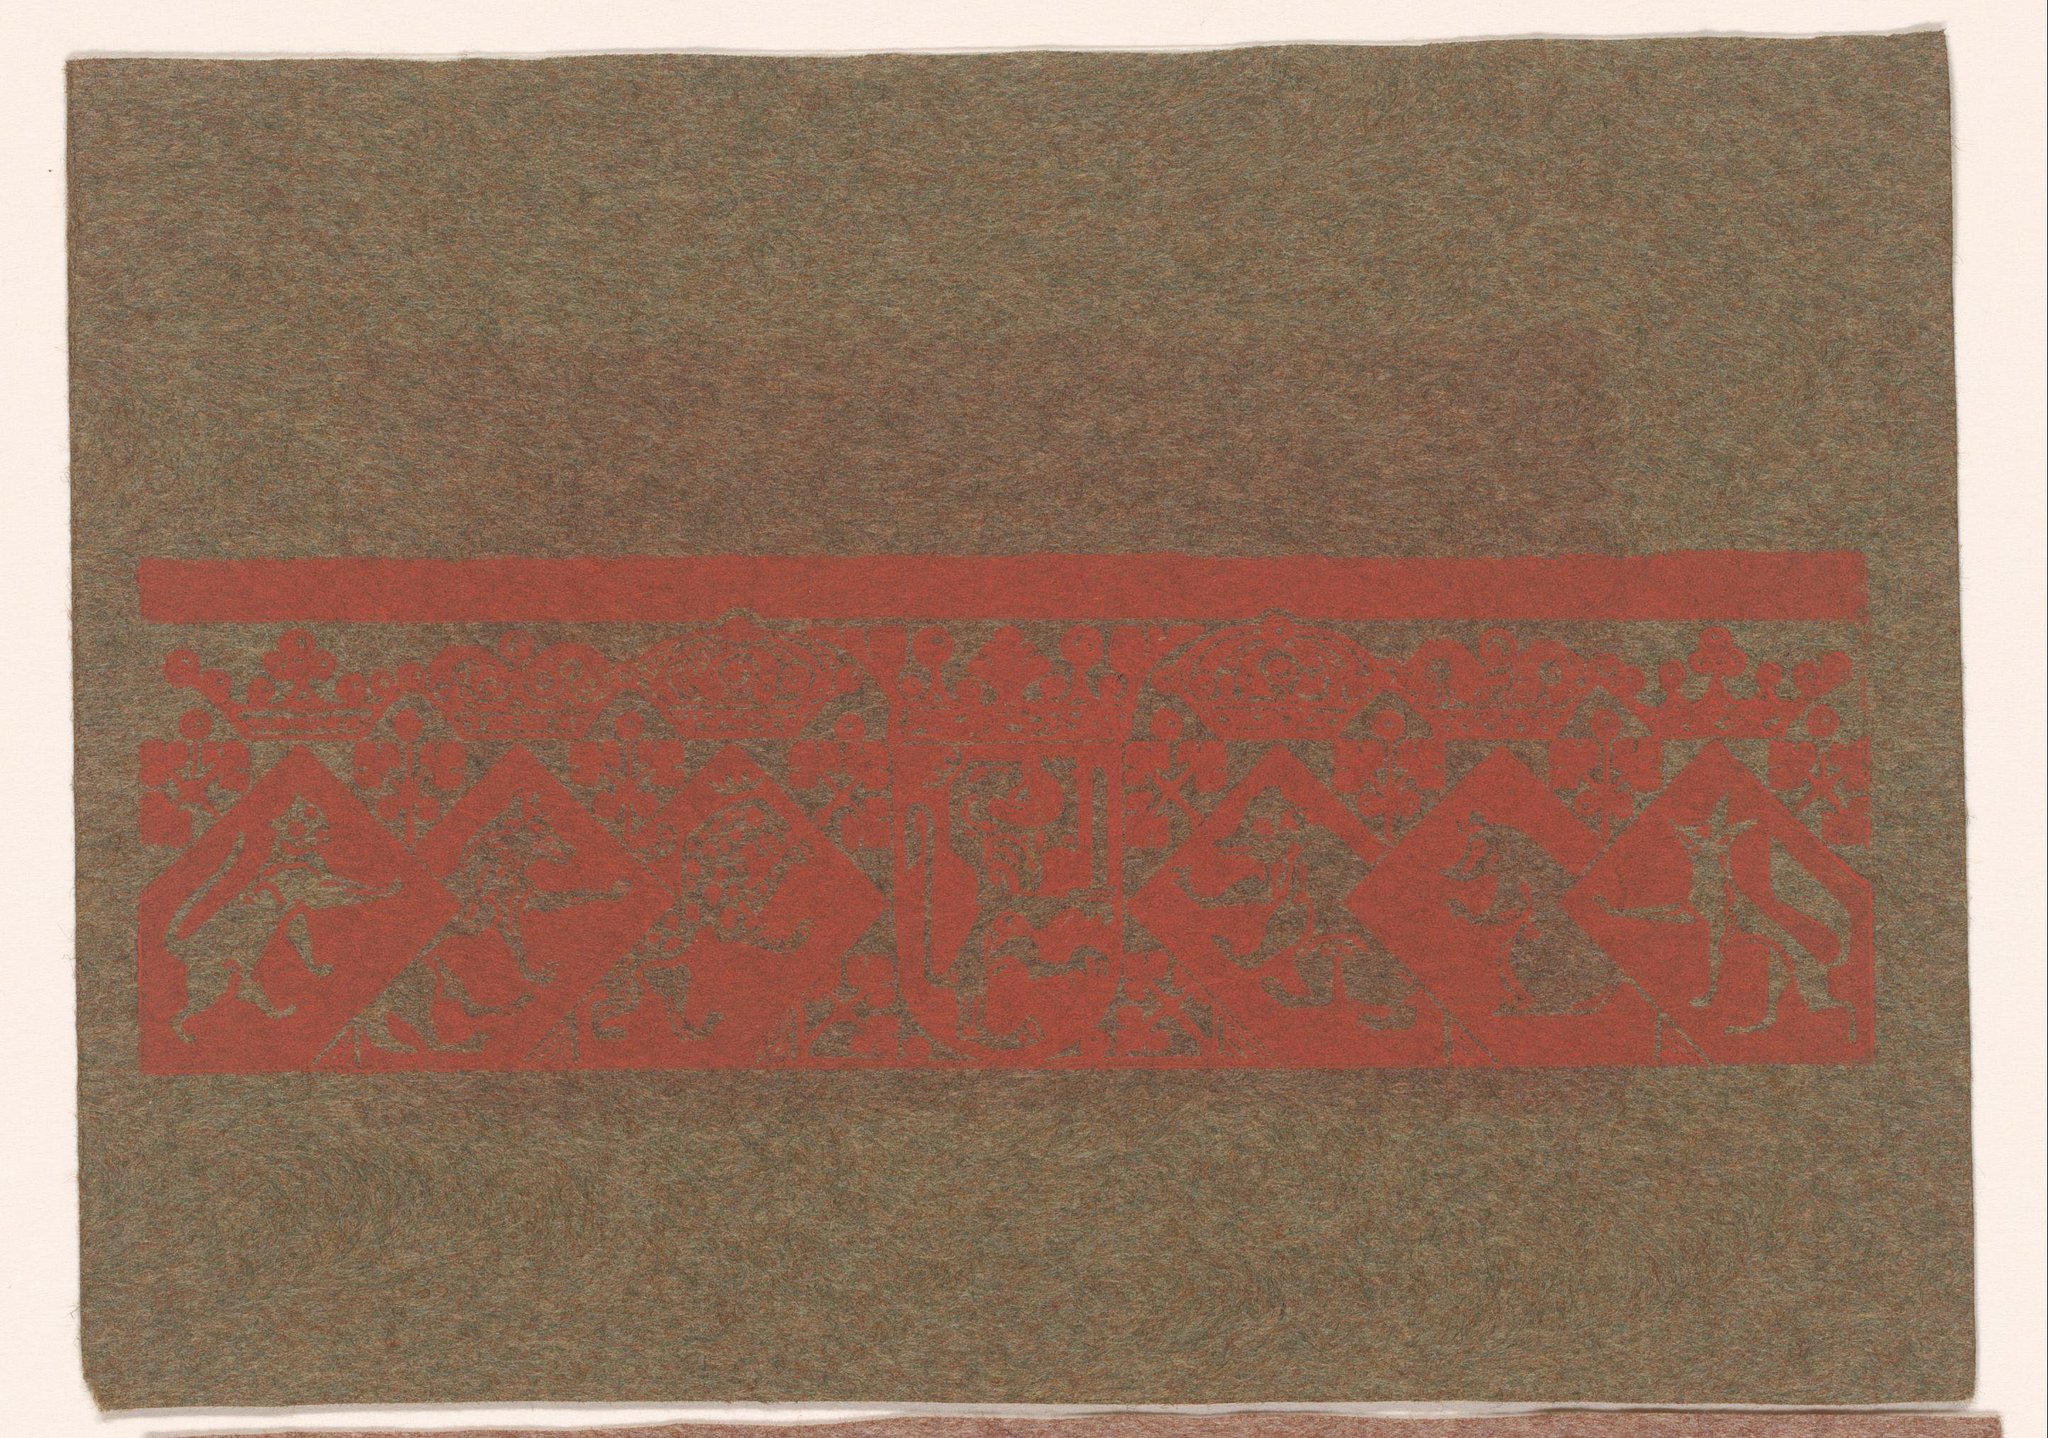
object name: boekillustratie ontwerp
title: Ornamentele rand met wapenschilden met dieren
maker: bernard willem wierink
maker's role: draughtsman, print maker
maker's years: 1856-1939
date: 1910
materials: paper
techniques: relief print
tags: fable of reynard the fox, armorial bearing, heraldry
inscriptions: collector's mark: Lugt 2228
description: Ontwerp voor: Streuvels, Stijn (Frank Lateur). Reinaert de Vos naar verschillende uitgaven van het middeleeuwsche epos. Amsterdam: L.J. Veen, 1910. Deze prent is vermoedelijk een plaatsnede, ook al wordt in de literatuur veelal gesproken over een houtsnede. Voor zover Wierink zijn prenten in hoogdruk zelf nader heeft omschreven, heeft hij altijd de term 'plaatsnede' gebruikt.